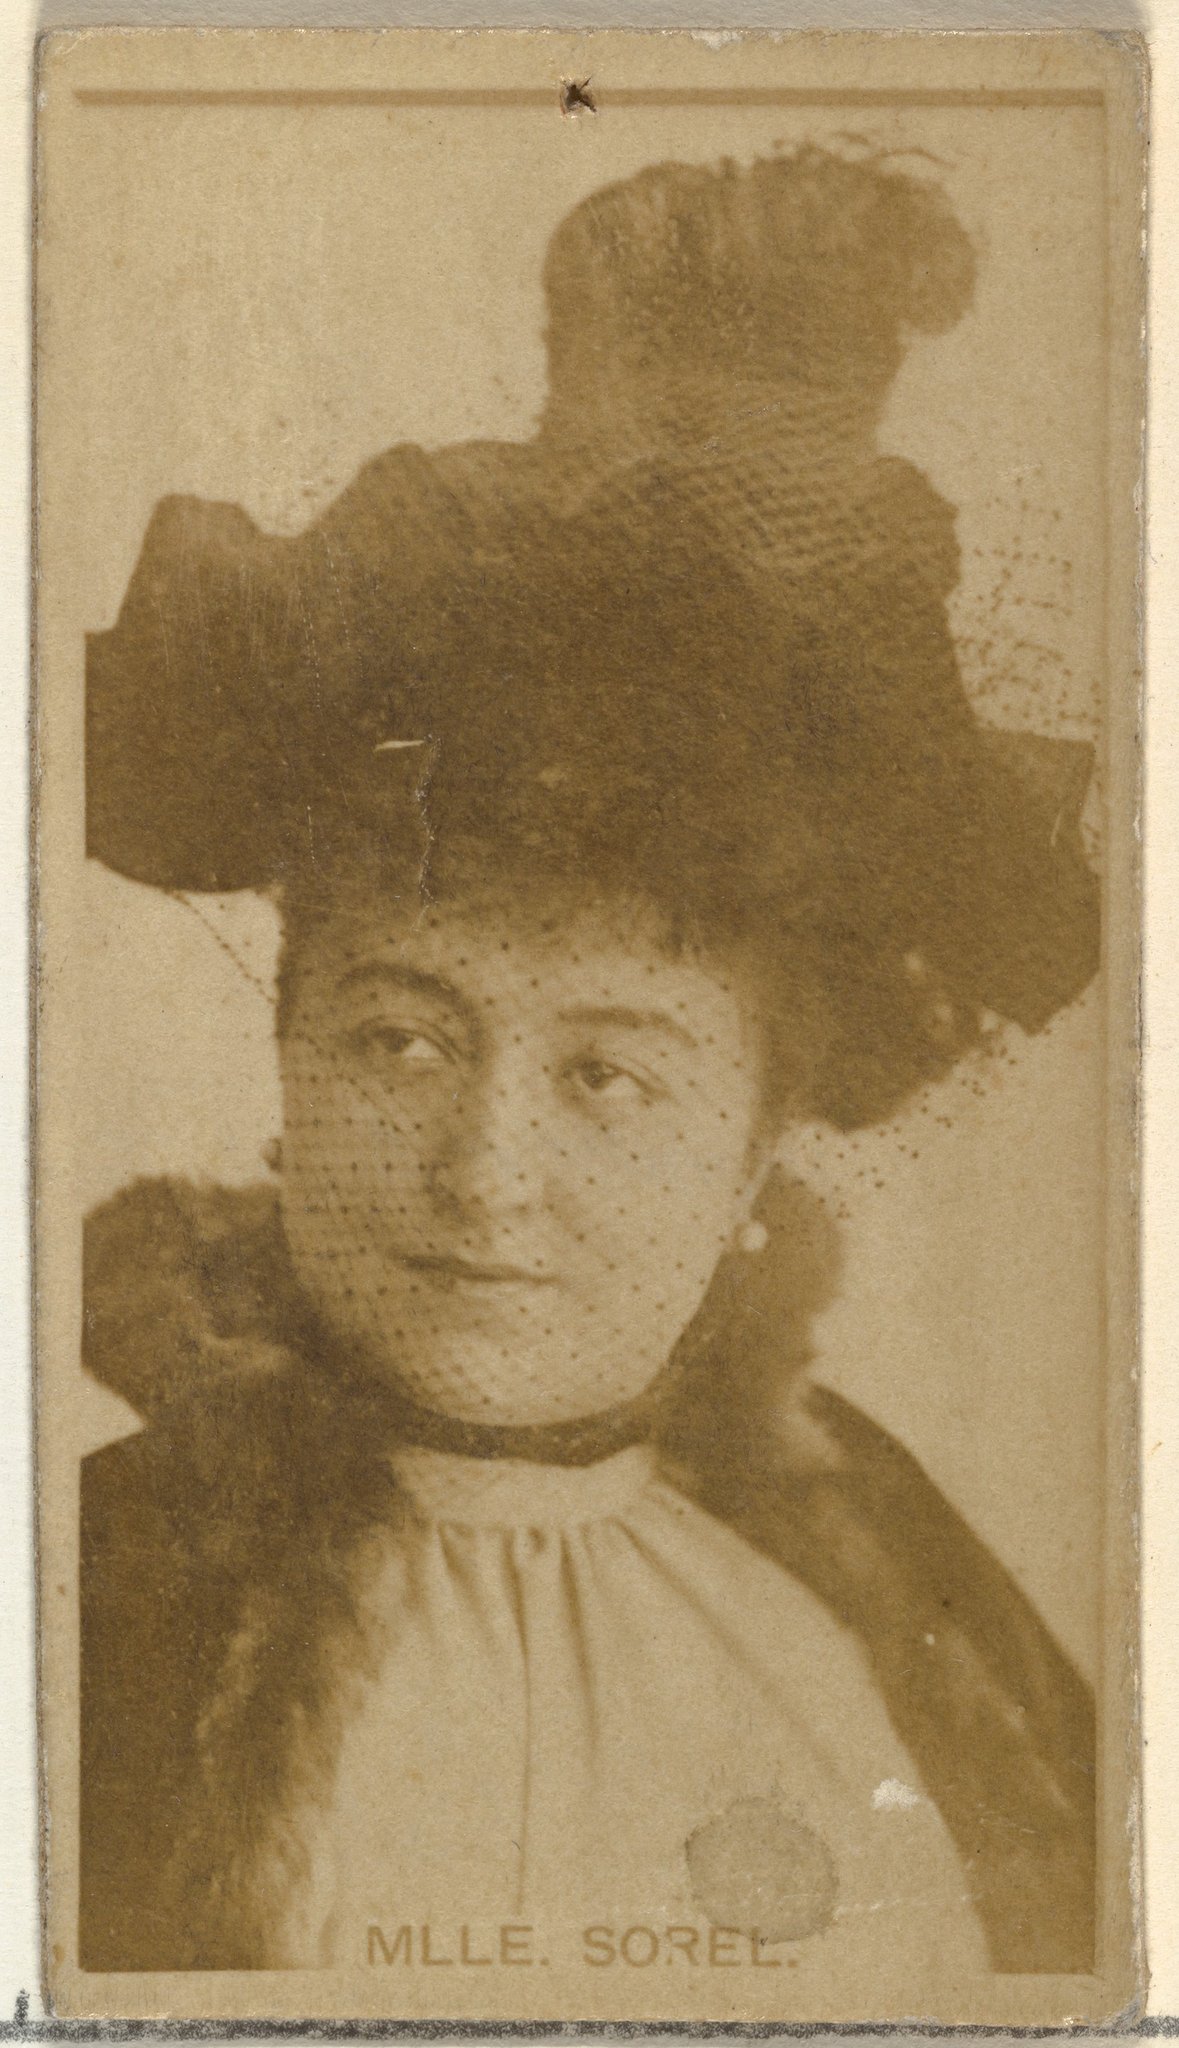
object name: photograph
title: Mlle. Sorel, from the Actors and Actresses series (N145-8) issued by Duke Sons & Co. to promote Duke Cigarettes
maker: w. duke, sons & co.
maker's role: publisher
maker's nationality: american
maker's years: 1870-1920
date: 1891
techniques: albumen silver print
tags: portraits,women,actresses